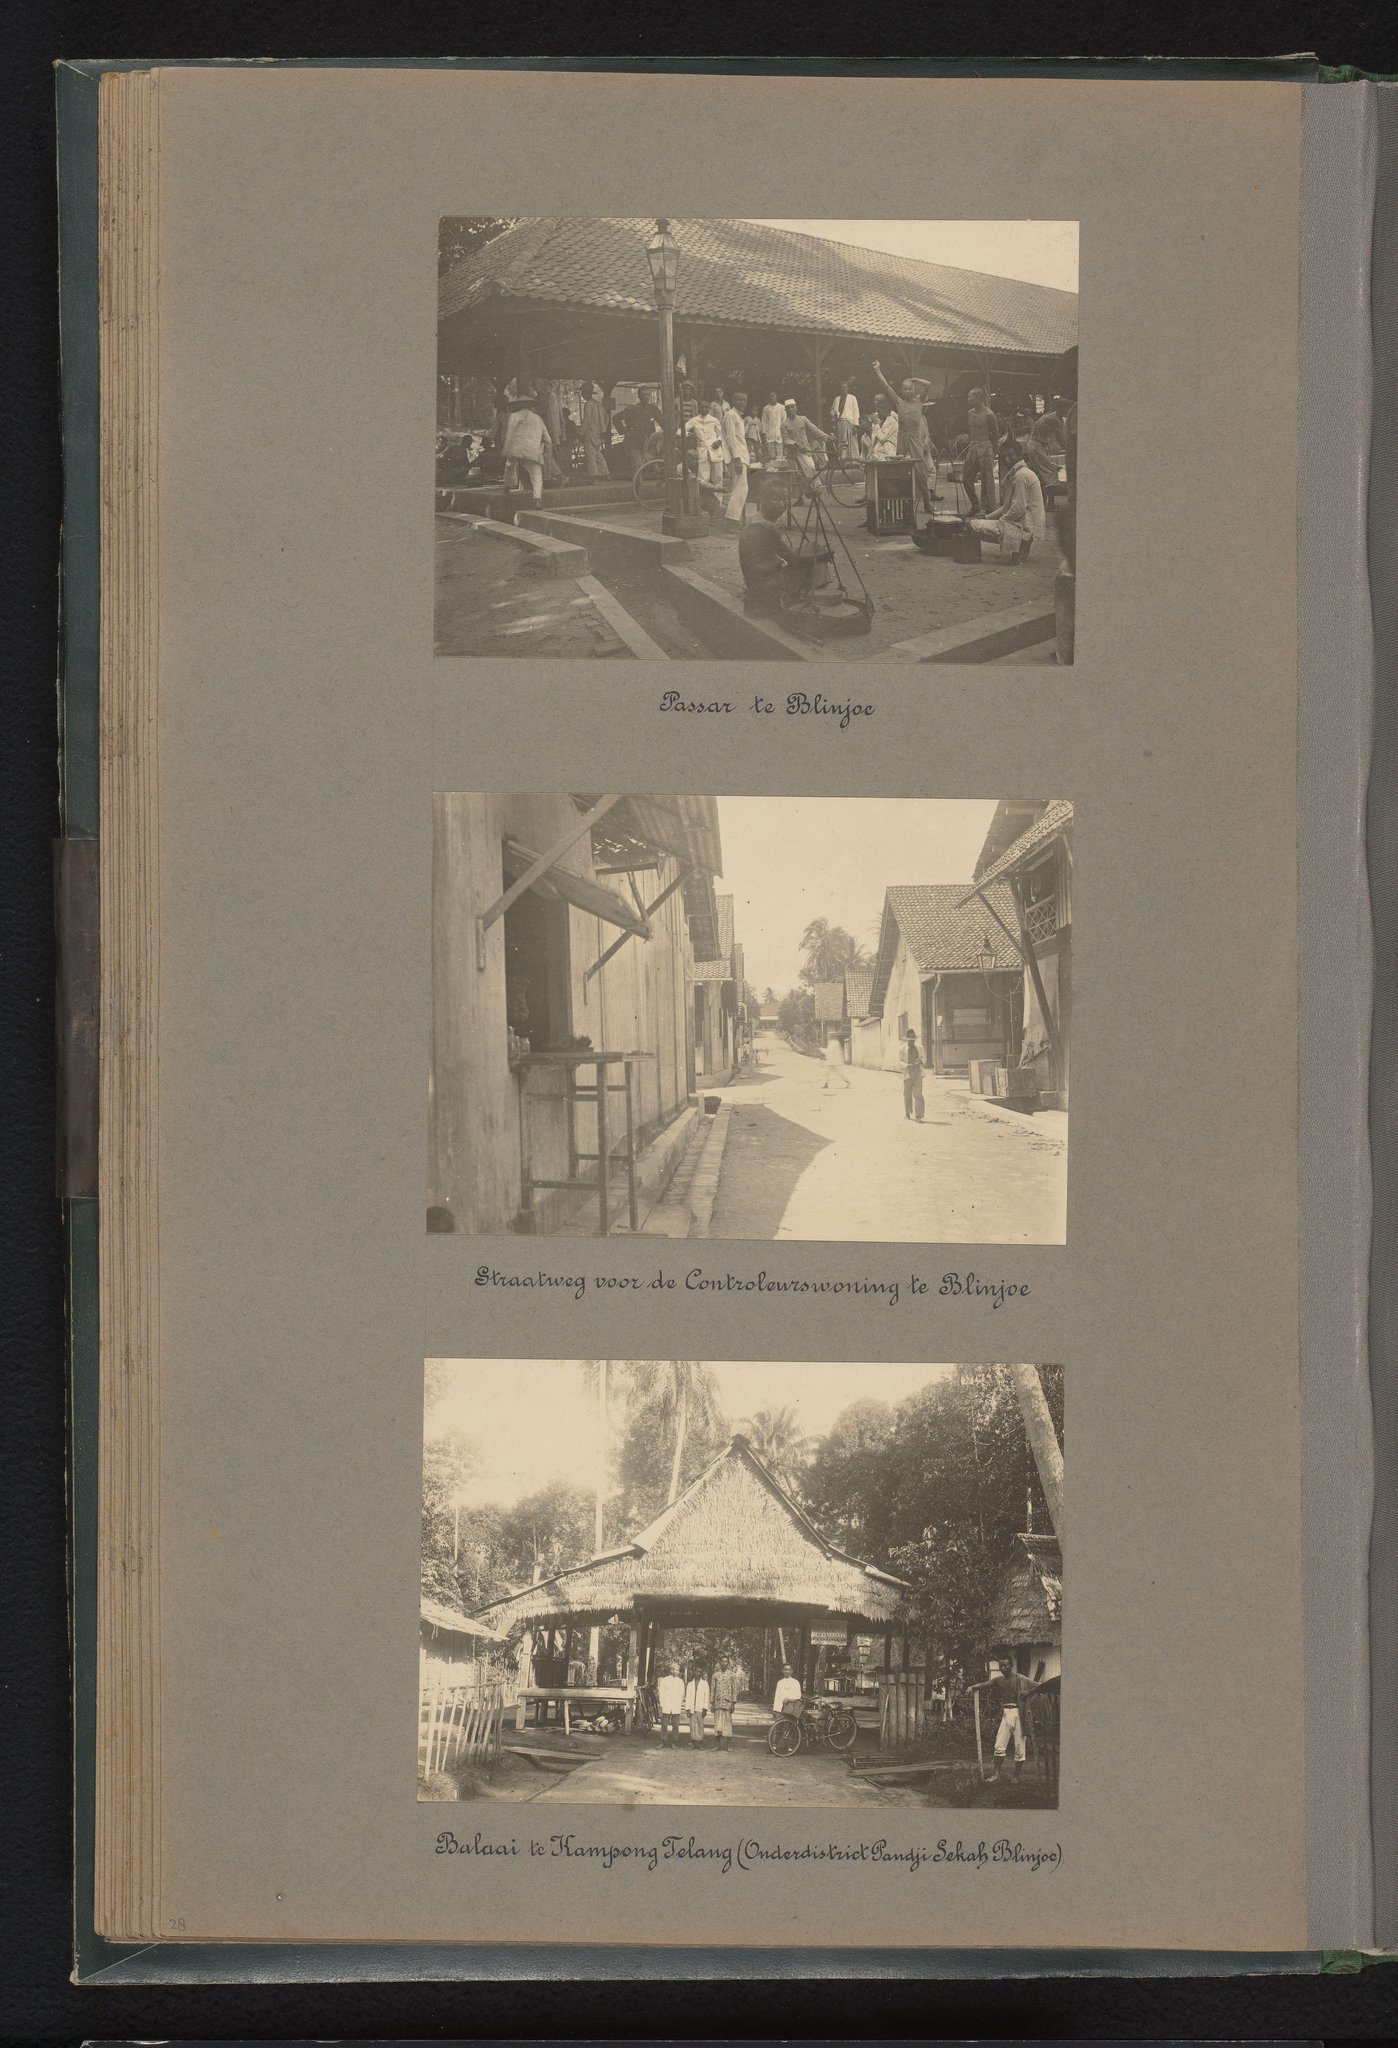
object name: album leaf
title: Passar, straat en lokale bewoners te Blinjoe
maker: Anonymous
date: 1914-1919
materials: cardboard, photographic support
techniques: gelatin silver print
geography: bangka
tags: robert julius boers, colonial system, mining, village street, market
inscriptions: inscription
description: Albumblad met drie foto's van de passar, een straat en lokale bewoners te Blinjoe. Onderdeel van het fotoalbum aangeboden aan Robert Julius Boers bij zijn vertrek naar Nederland in 1919 door het personeel van de Banka-tinwinning.